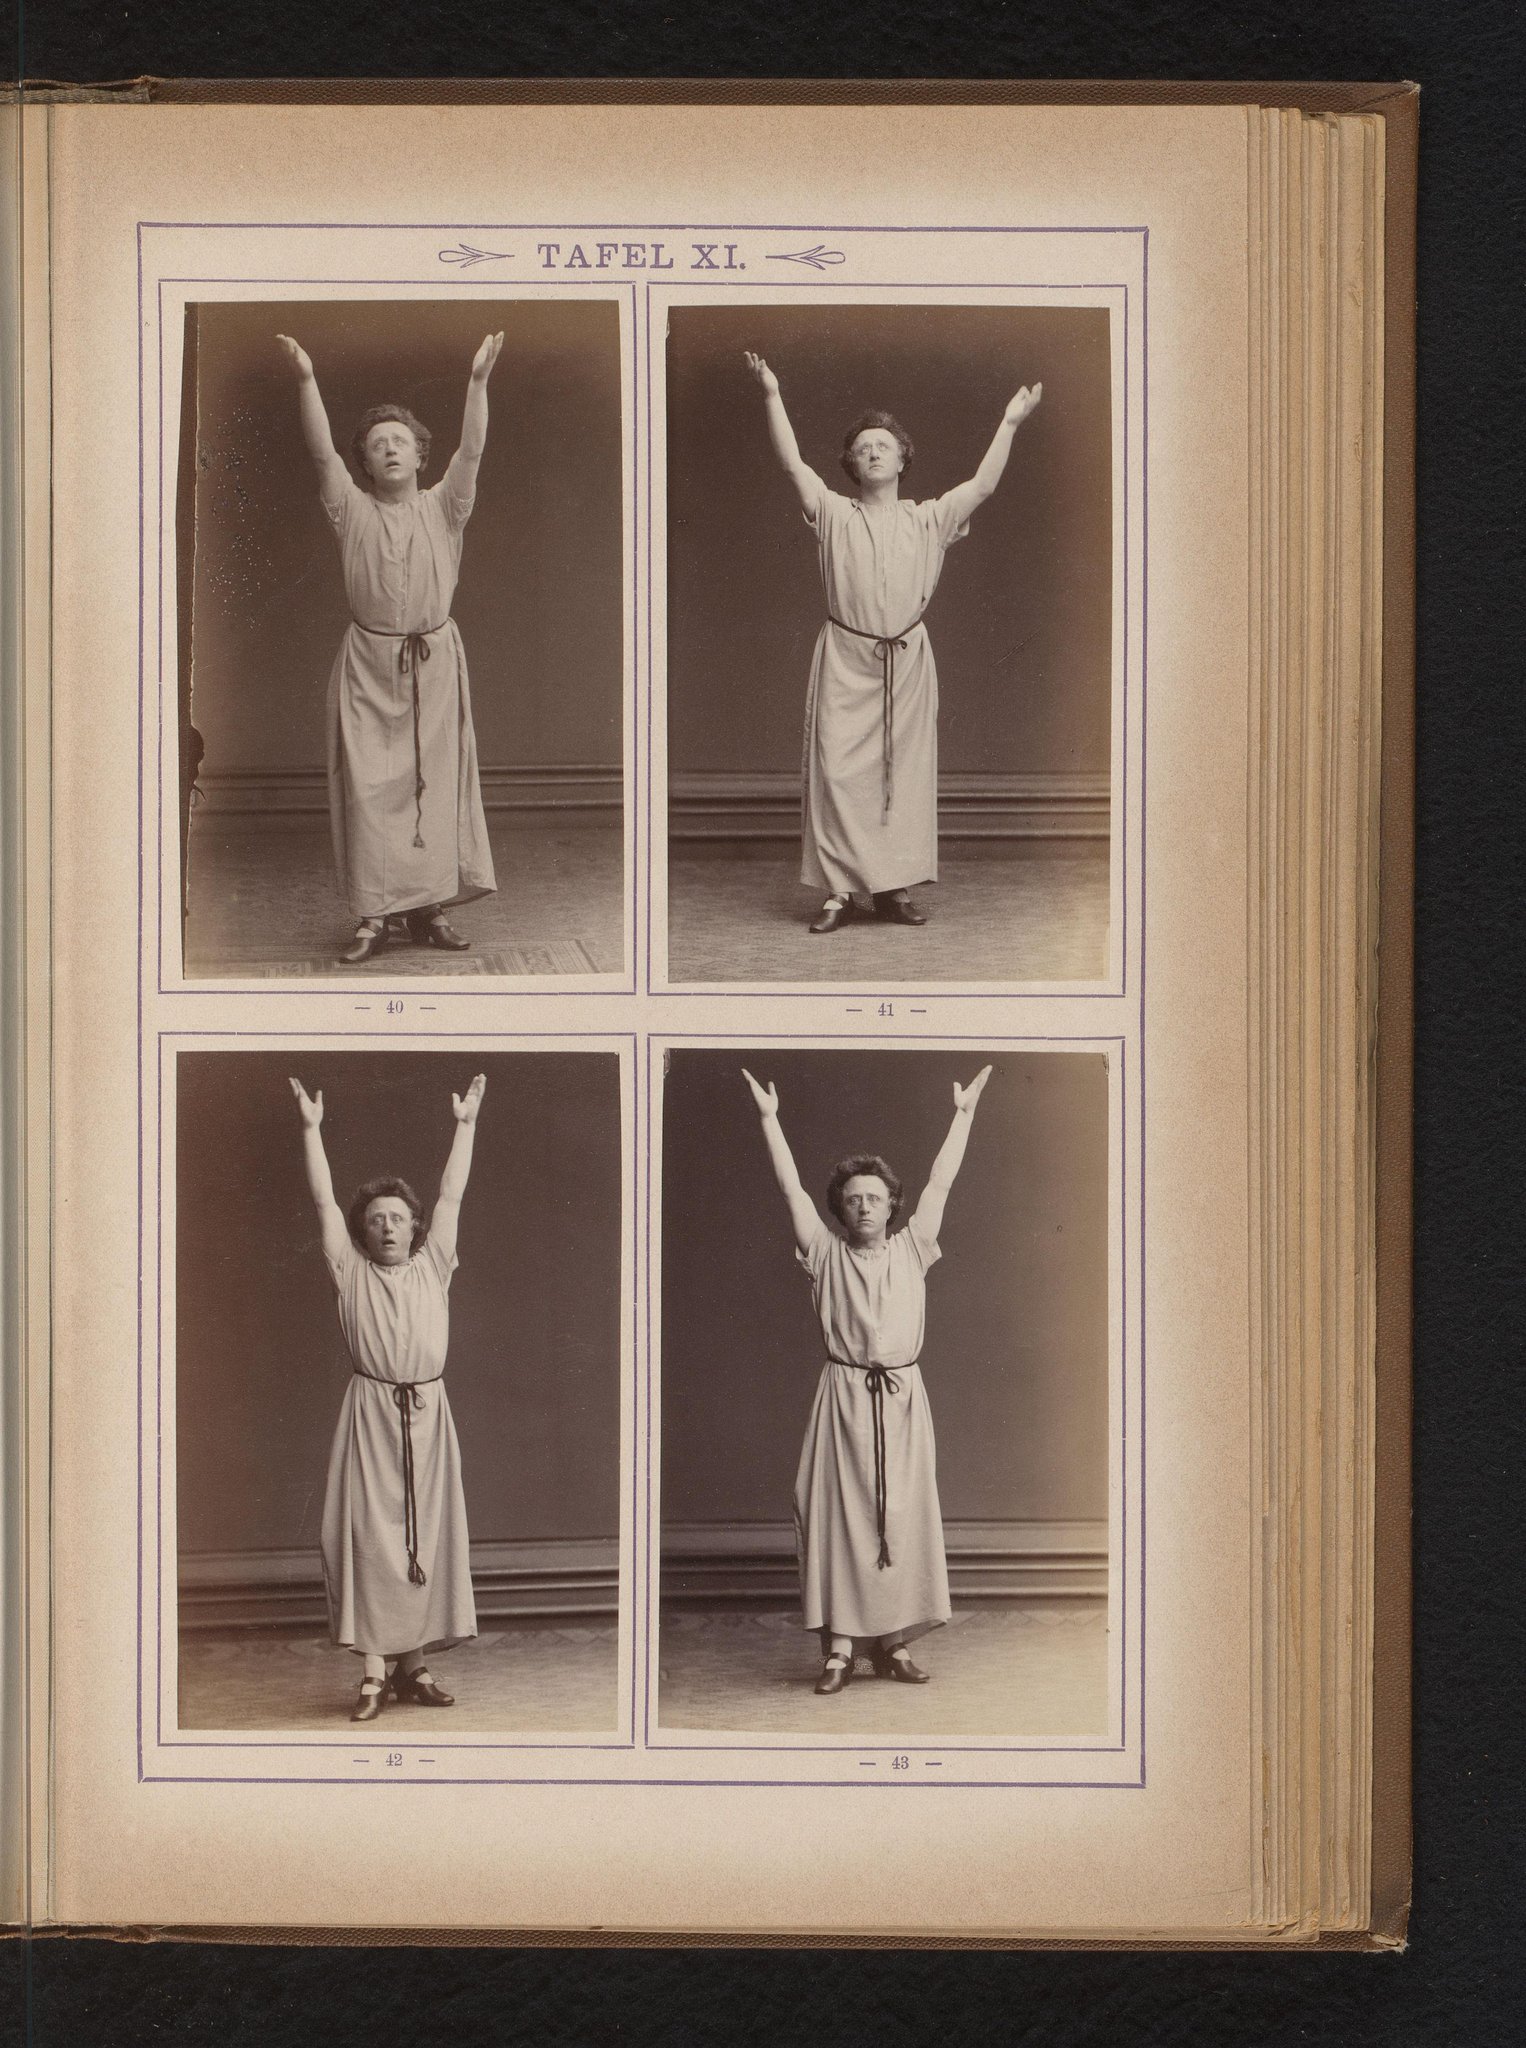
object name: page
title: Vier portretten van een man in verschillende poses met naar boven gestrekte armen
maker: nicola tonger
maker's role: fotograaf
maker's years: 1846-1917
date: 1881-1886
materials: paper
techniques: albumen print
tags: gesture-language, arm raised, with fingers spread out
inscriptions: number: ‘40- 43’, number: ‘TAFEL XI.’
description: Foto op eenentwintigste ongenummerde pagina na pagina 6.